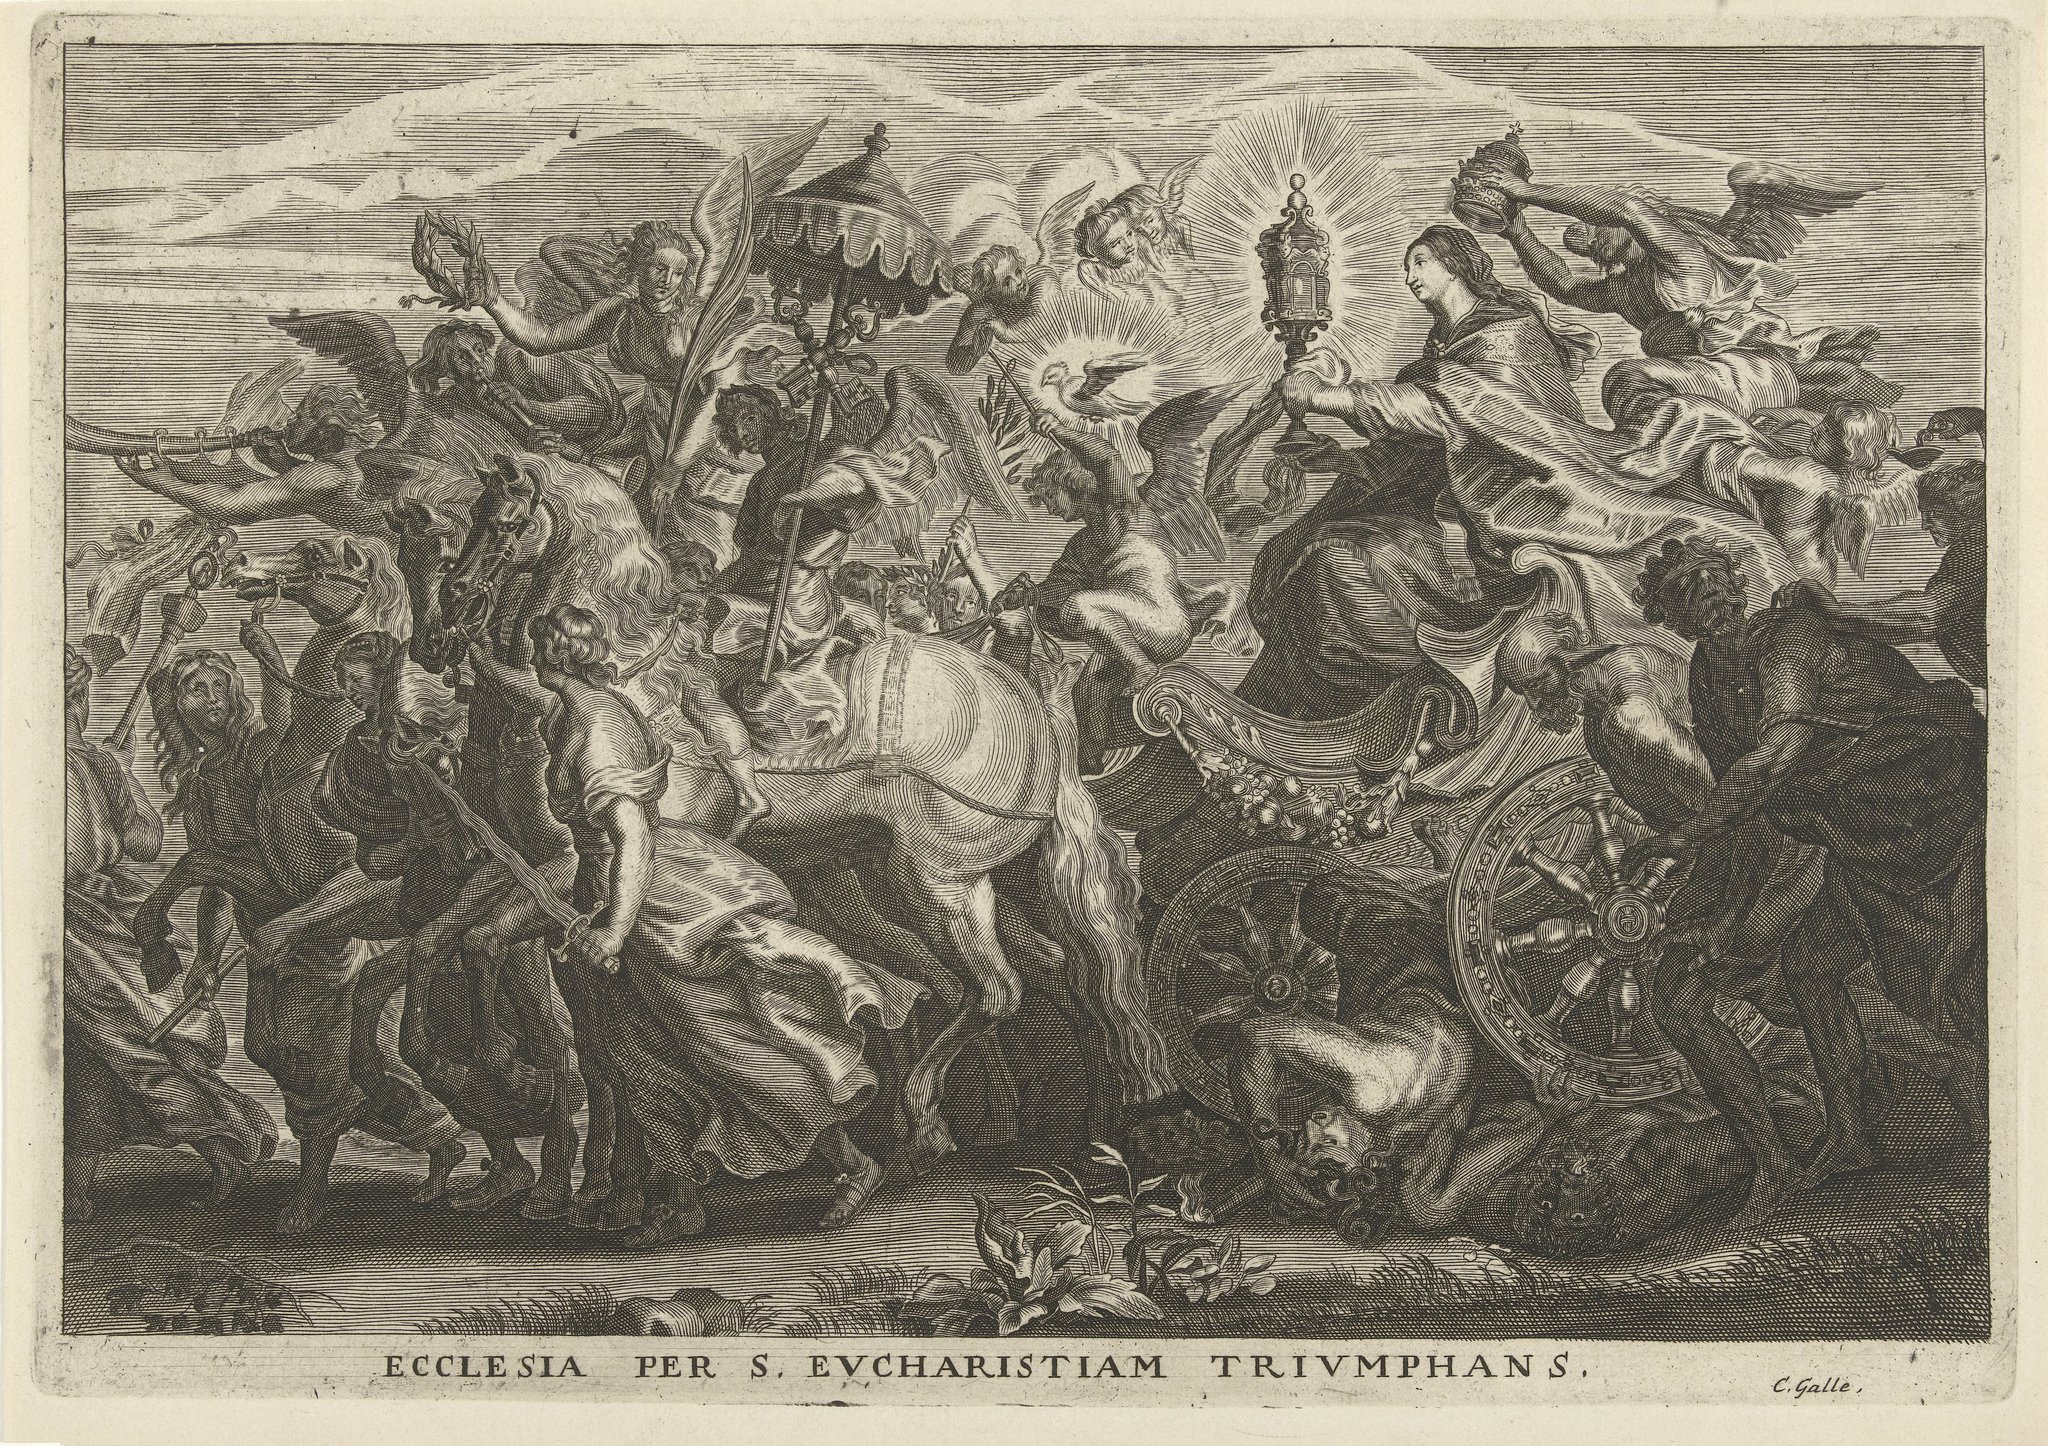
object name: print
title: Ecclesia per S. Evcharistiam Trivmphans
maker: cornelis galle (i)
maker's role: print maker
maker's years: 1576-1650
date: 1586-1650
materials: paper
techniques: engraving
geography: southern netherlands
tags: envy; 'invidia' (ripa) ~ personification of one of the seven deadly sins, chariot, triumphal car, glorification, triumph of the eucharist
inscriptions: collector's mark: Lugt 2228, collector's mark: Lugt 2760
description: De personificatie van de Kerk zit op een triomfwagen die begeleidt wordt door engelen. Ze houdt een monstrans met beide handen vast en wordt gekroond met een tiara. De wagen rijdt over de vijanden van de kerk. Te herkennen is Afgunst met haar slangenhoofd. Links naast de wagen lopen twee gevangenen. Een man met ezelsoren en een geblinddoekte oudere man.